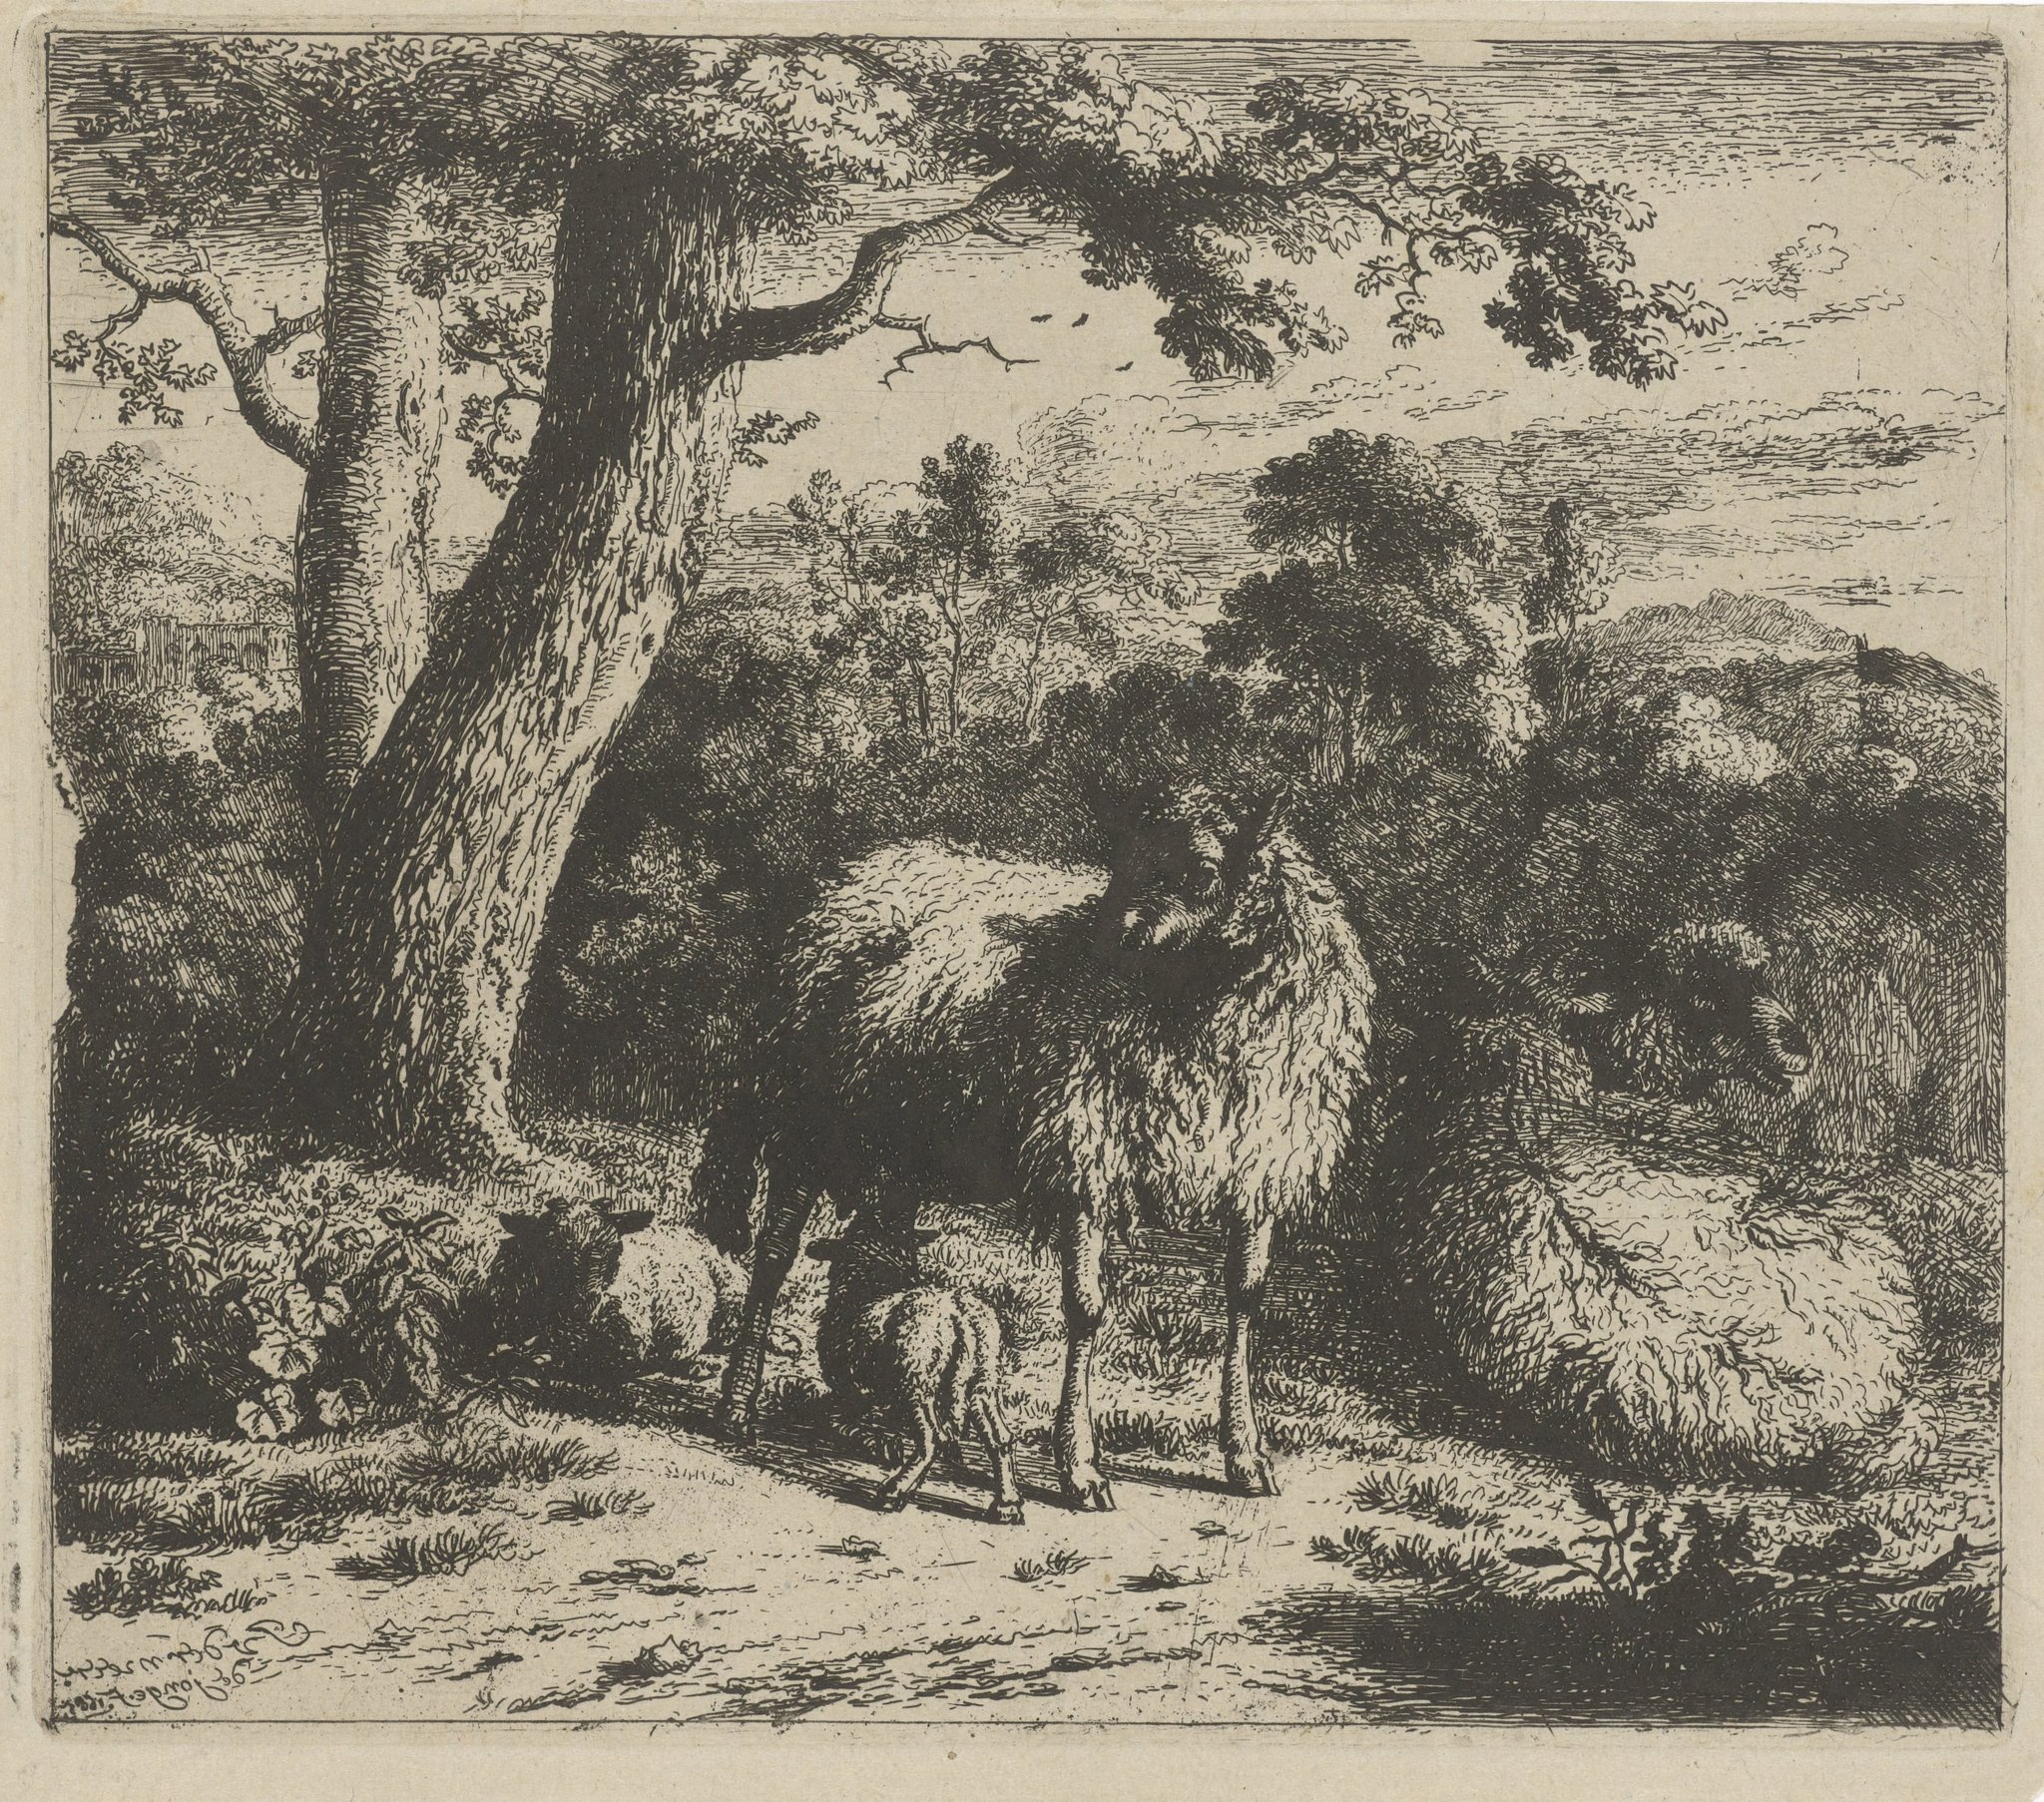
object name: print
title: Staand schaap met twee lammeren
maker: jan van der meer (ii)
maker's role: draughtsman, print maker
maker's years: 1656-1705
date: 1685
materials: paper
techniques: etching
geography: haarlem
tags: sheep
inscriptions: collector's mark: Lugt 654, collector's mark: Lugt 1687, collector's mark: Lugt 2228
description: Een staand en een liggend schaap in een landschap. Een lam drinkt bij het staande schaap, een ander lammetje ligt daarachter.